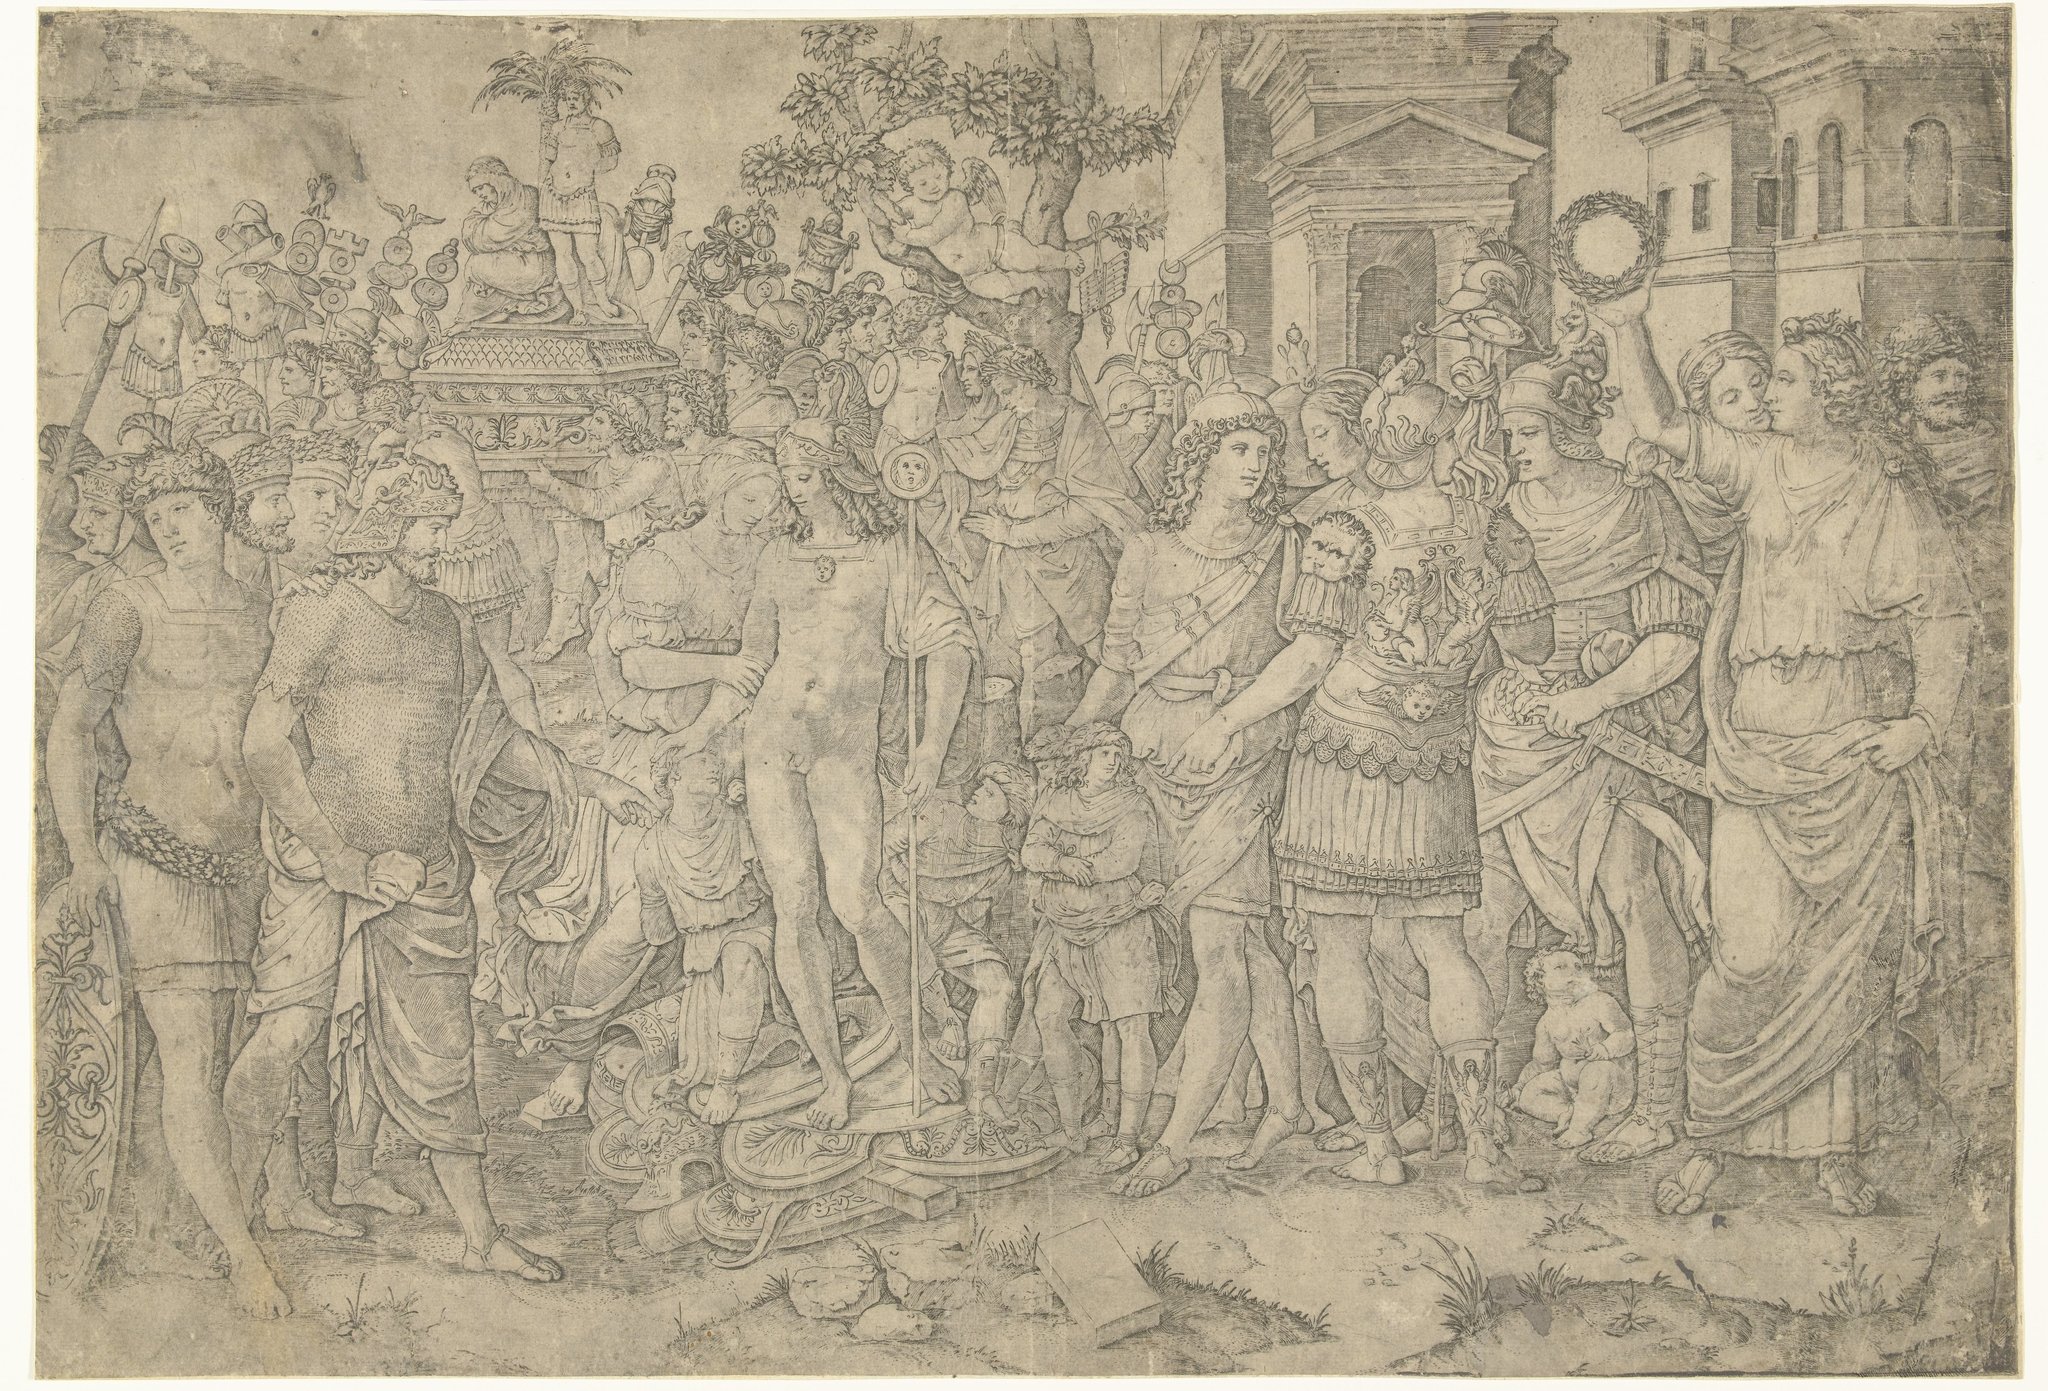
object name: print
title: Triomftocht van Romeinse keizer met soldaten en buitgemaakte wapenrustingen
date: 1510-1527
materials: paper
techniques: engraving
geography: italy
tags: triumphs (allegorical and symbolic), conqueror triumphing, triumphal entry of victor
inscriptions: collector's mark: Lugt 240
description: Prent mogelijk naar ontwerp van Andrea Mantegna.